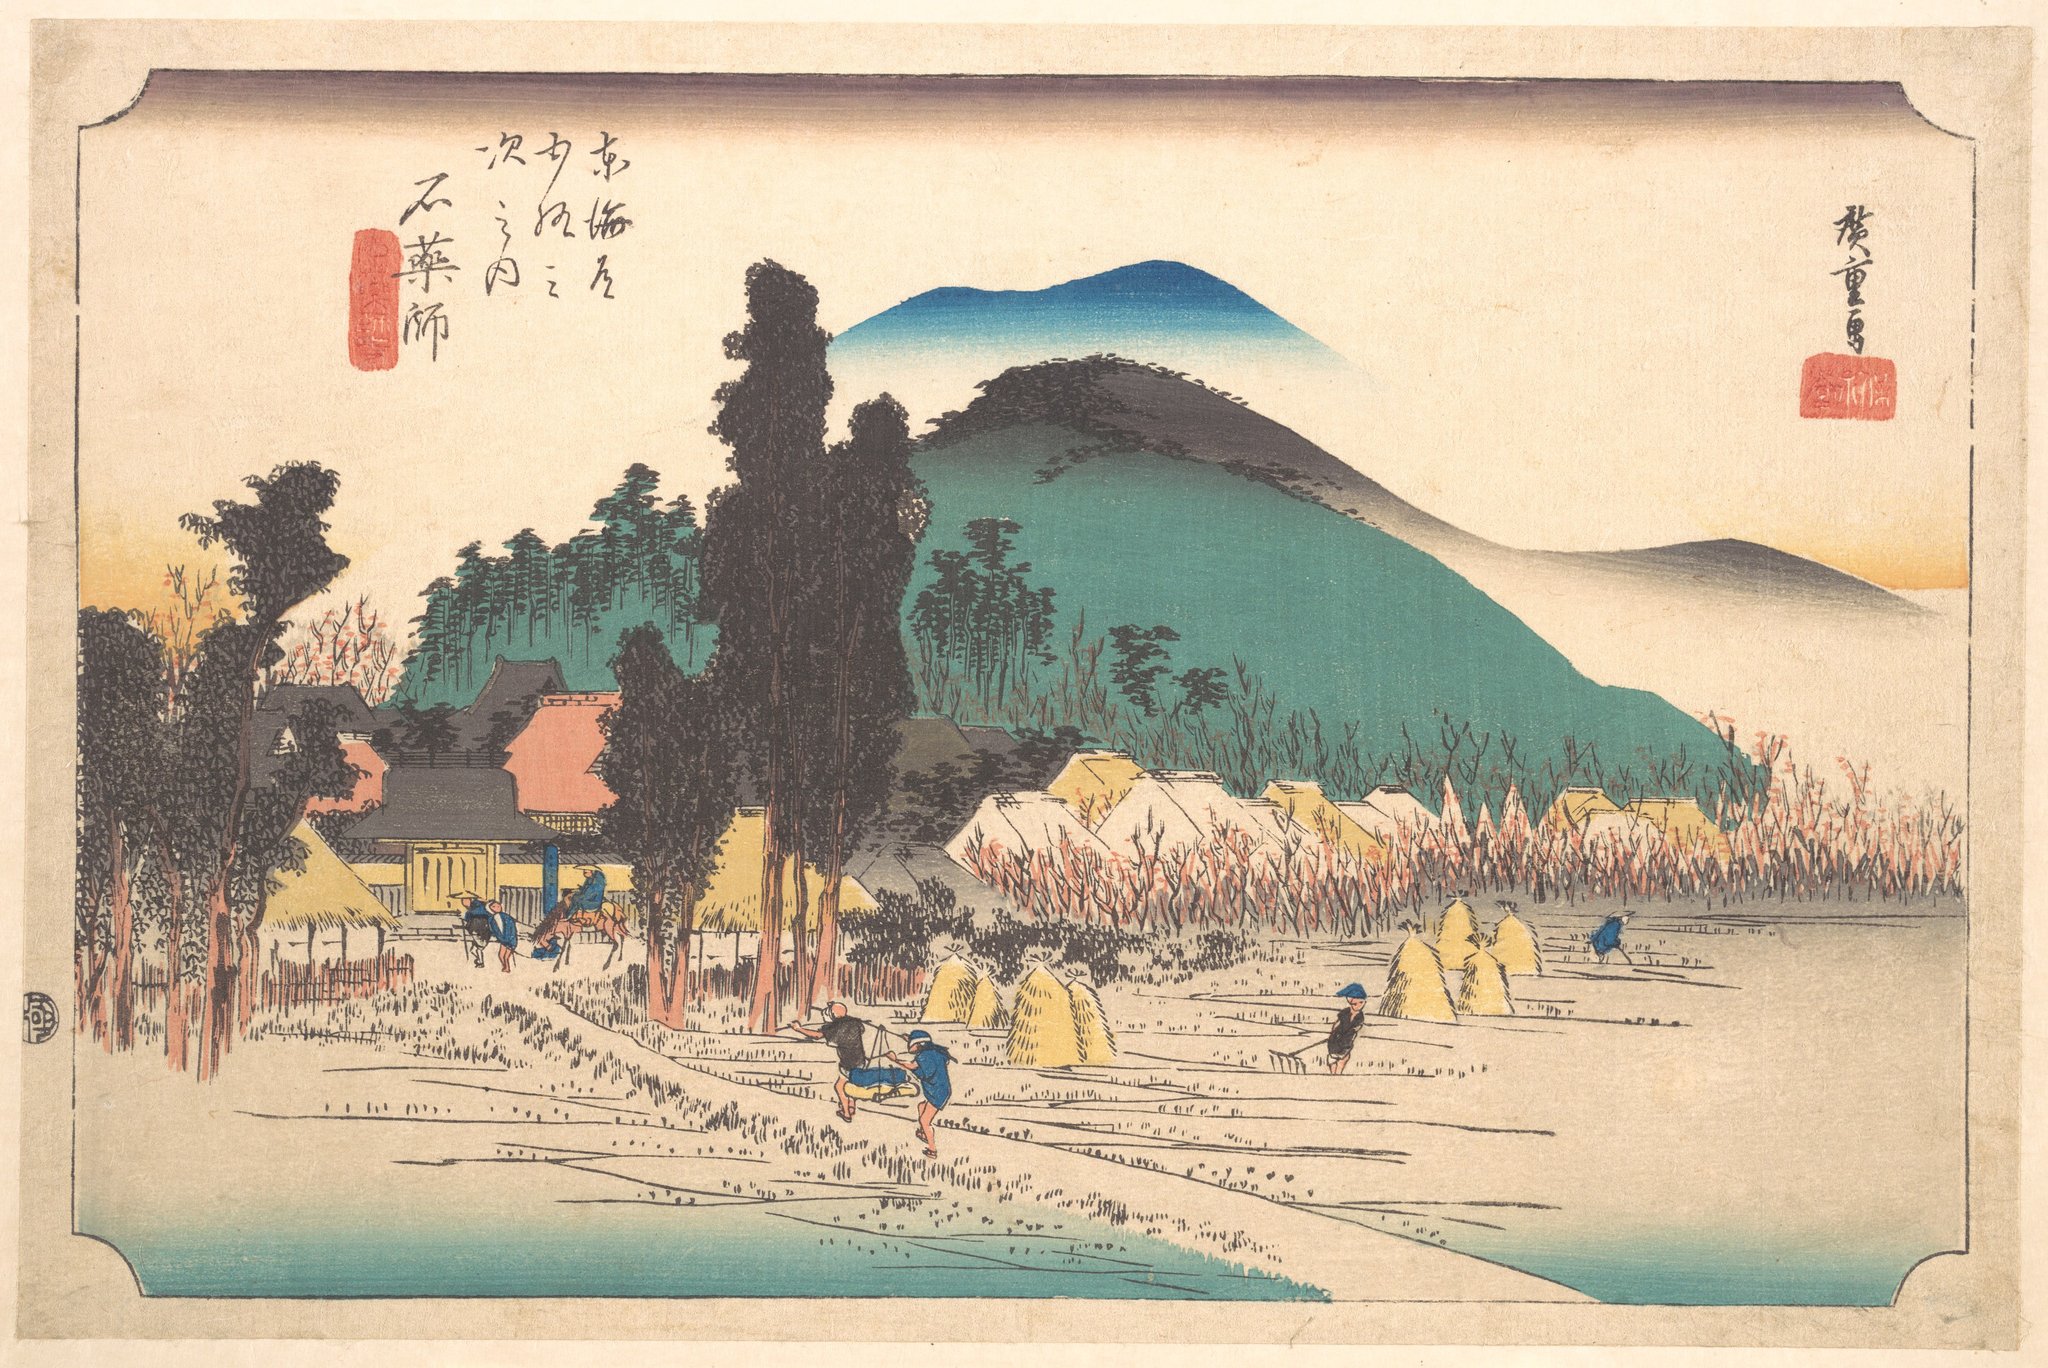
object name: print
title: The Ishiyakushi Temple at Ishiyakushi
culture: japanese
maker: utagawa hiroshige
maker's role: artist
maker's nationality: japanese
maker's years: 1797-1858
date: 1834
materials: ink, paper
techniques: woodblock print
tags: human figures,temples,mountains,trees